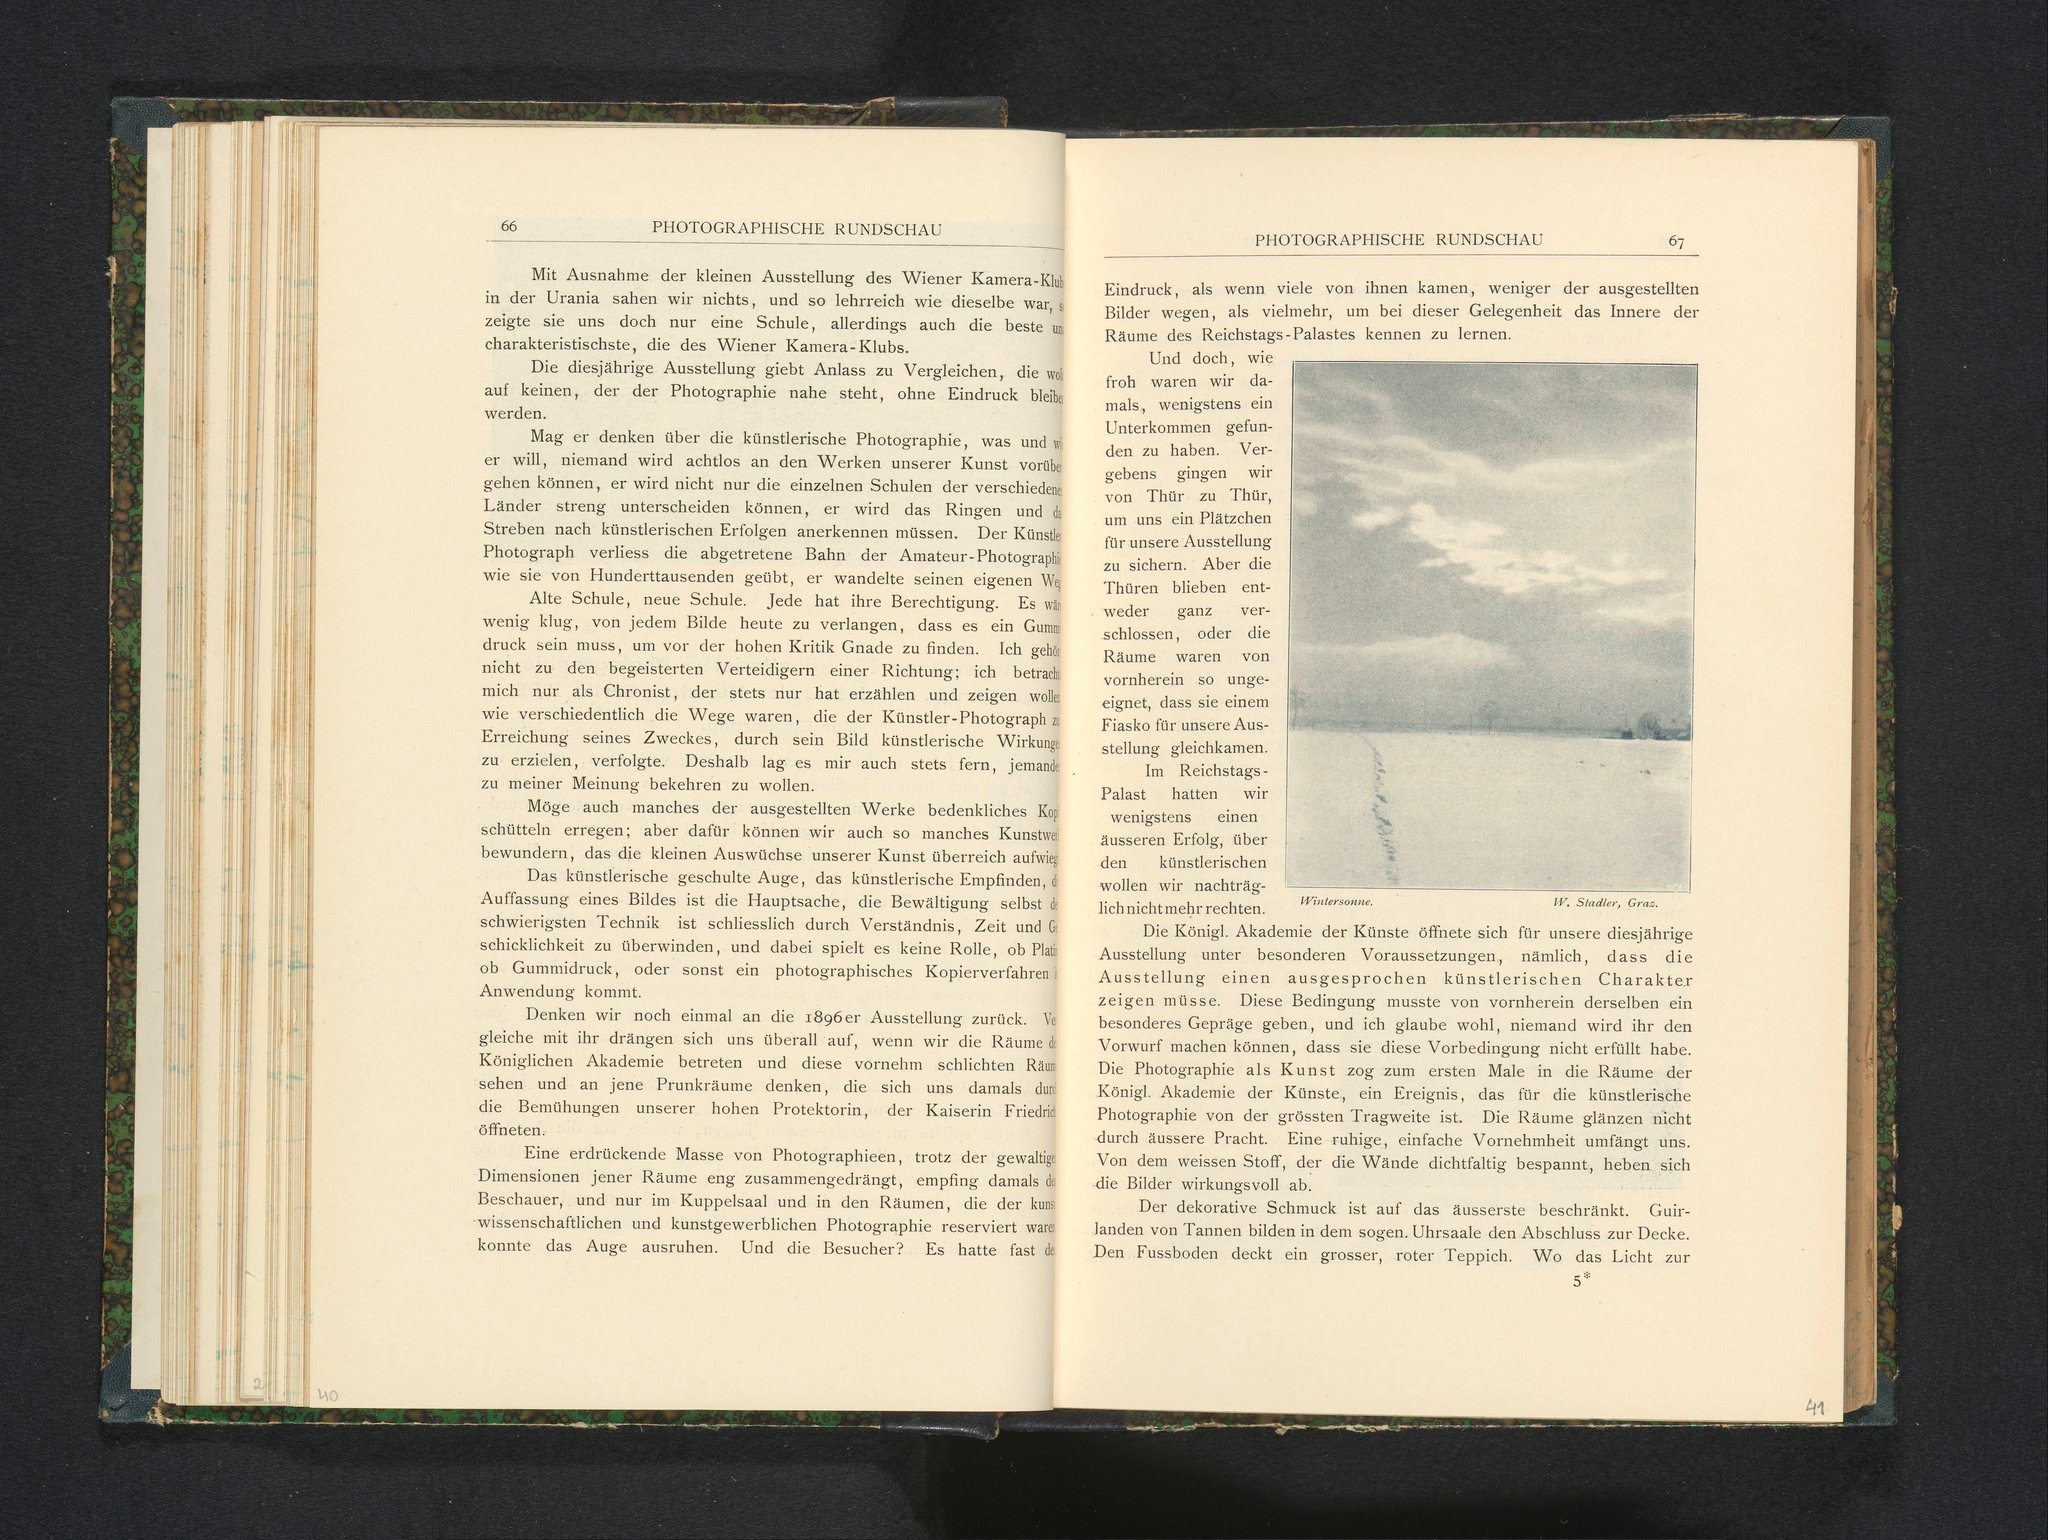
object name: photomechanical print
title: Winterlandschap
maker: wilhelm stadler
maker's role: fotograaf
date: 1894-1899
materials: paper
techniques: autotype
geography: berlin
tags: landscapes, snow